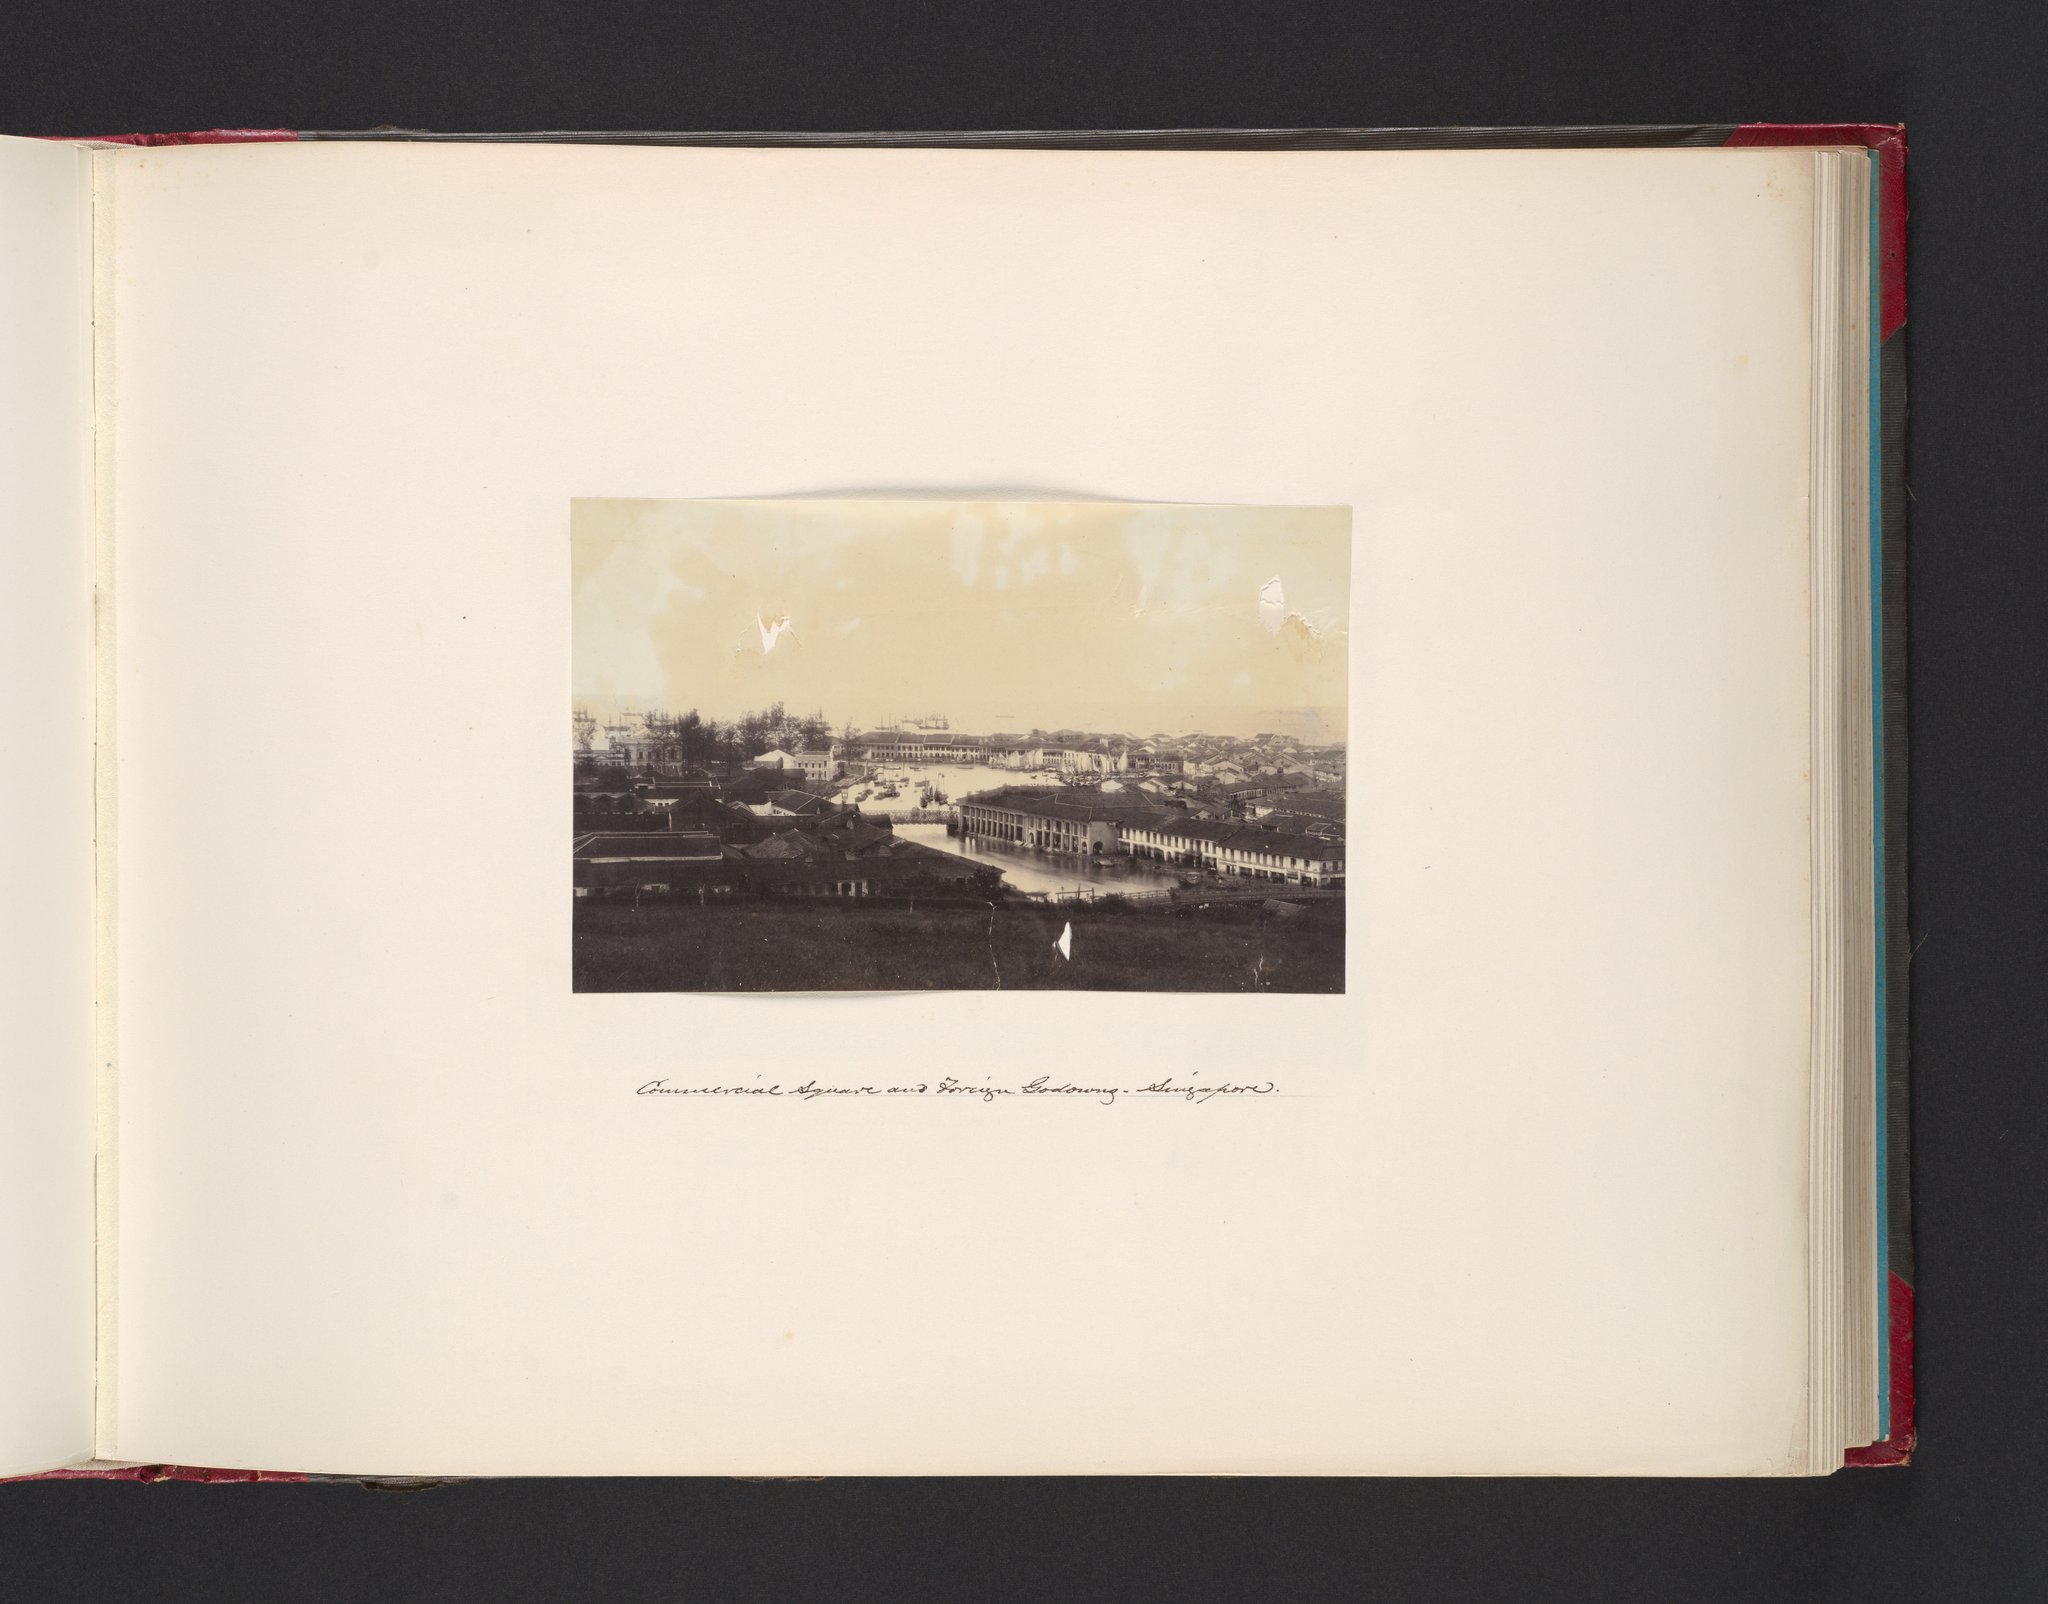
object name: photograph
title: [Commercial Singapore]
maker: john thomson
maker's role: artist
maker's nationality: british, scottish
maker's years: 1837-1921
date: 1865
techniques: albumen silver print, glass negative